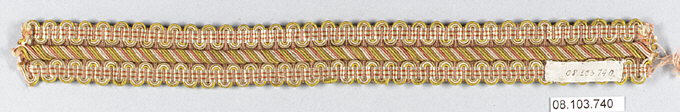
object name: gimp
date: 1834-1866